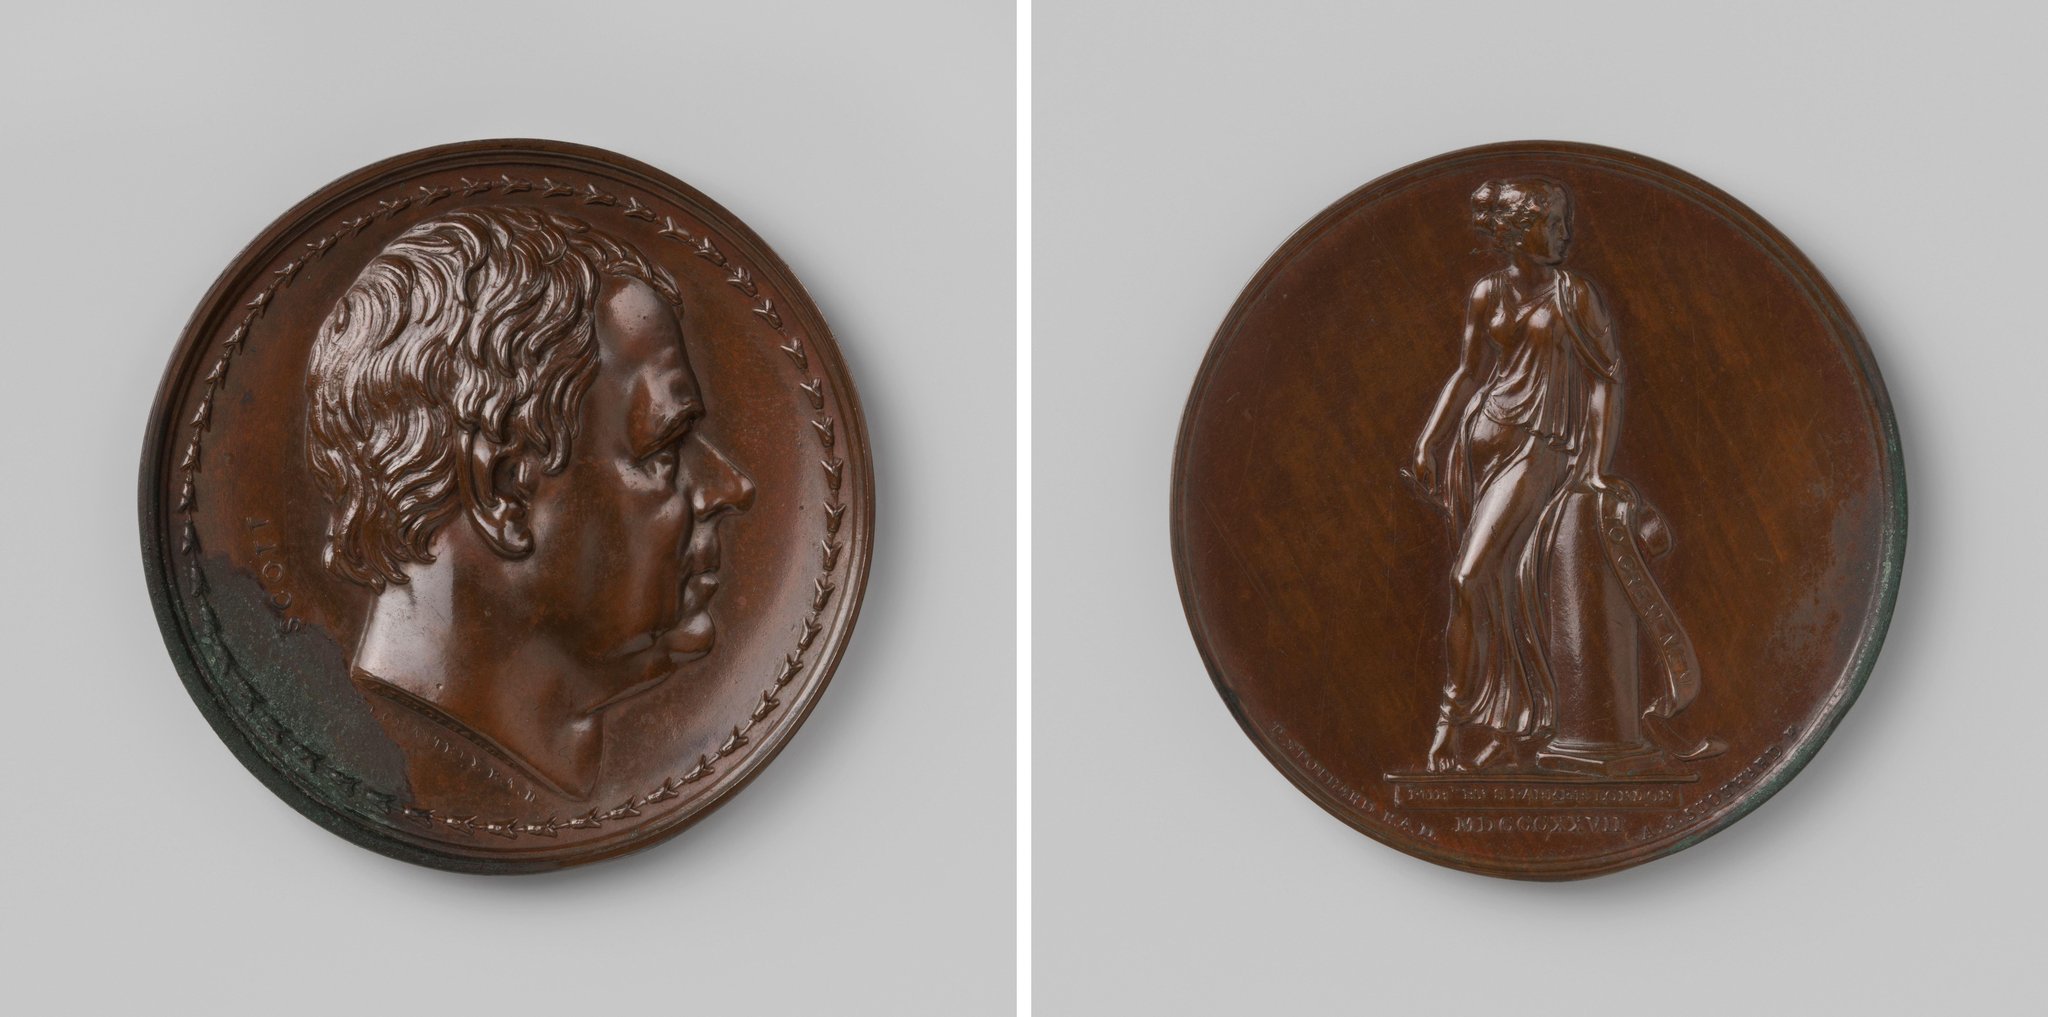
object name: history medal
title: Sir Walter Scott, Engels schrijver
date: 1827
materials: bronze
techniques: striking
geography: england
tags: walter scott